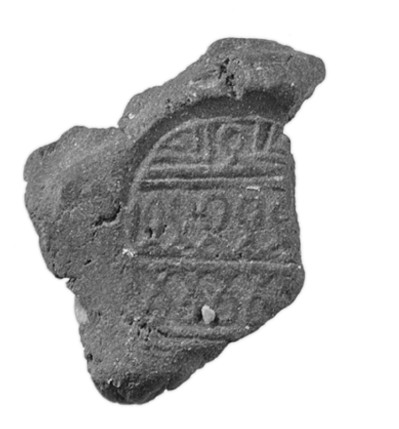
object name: sealing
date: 2030-1640 BCE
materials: clay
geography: egypt